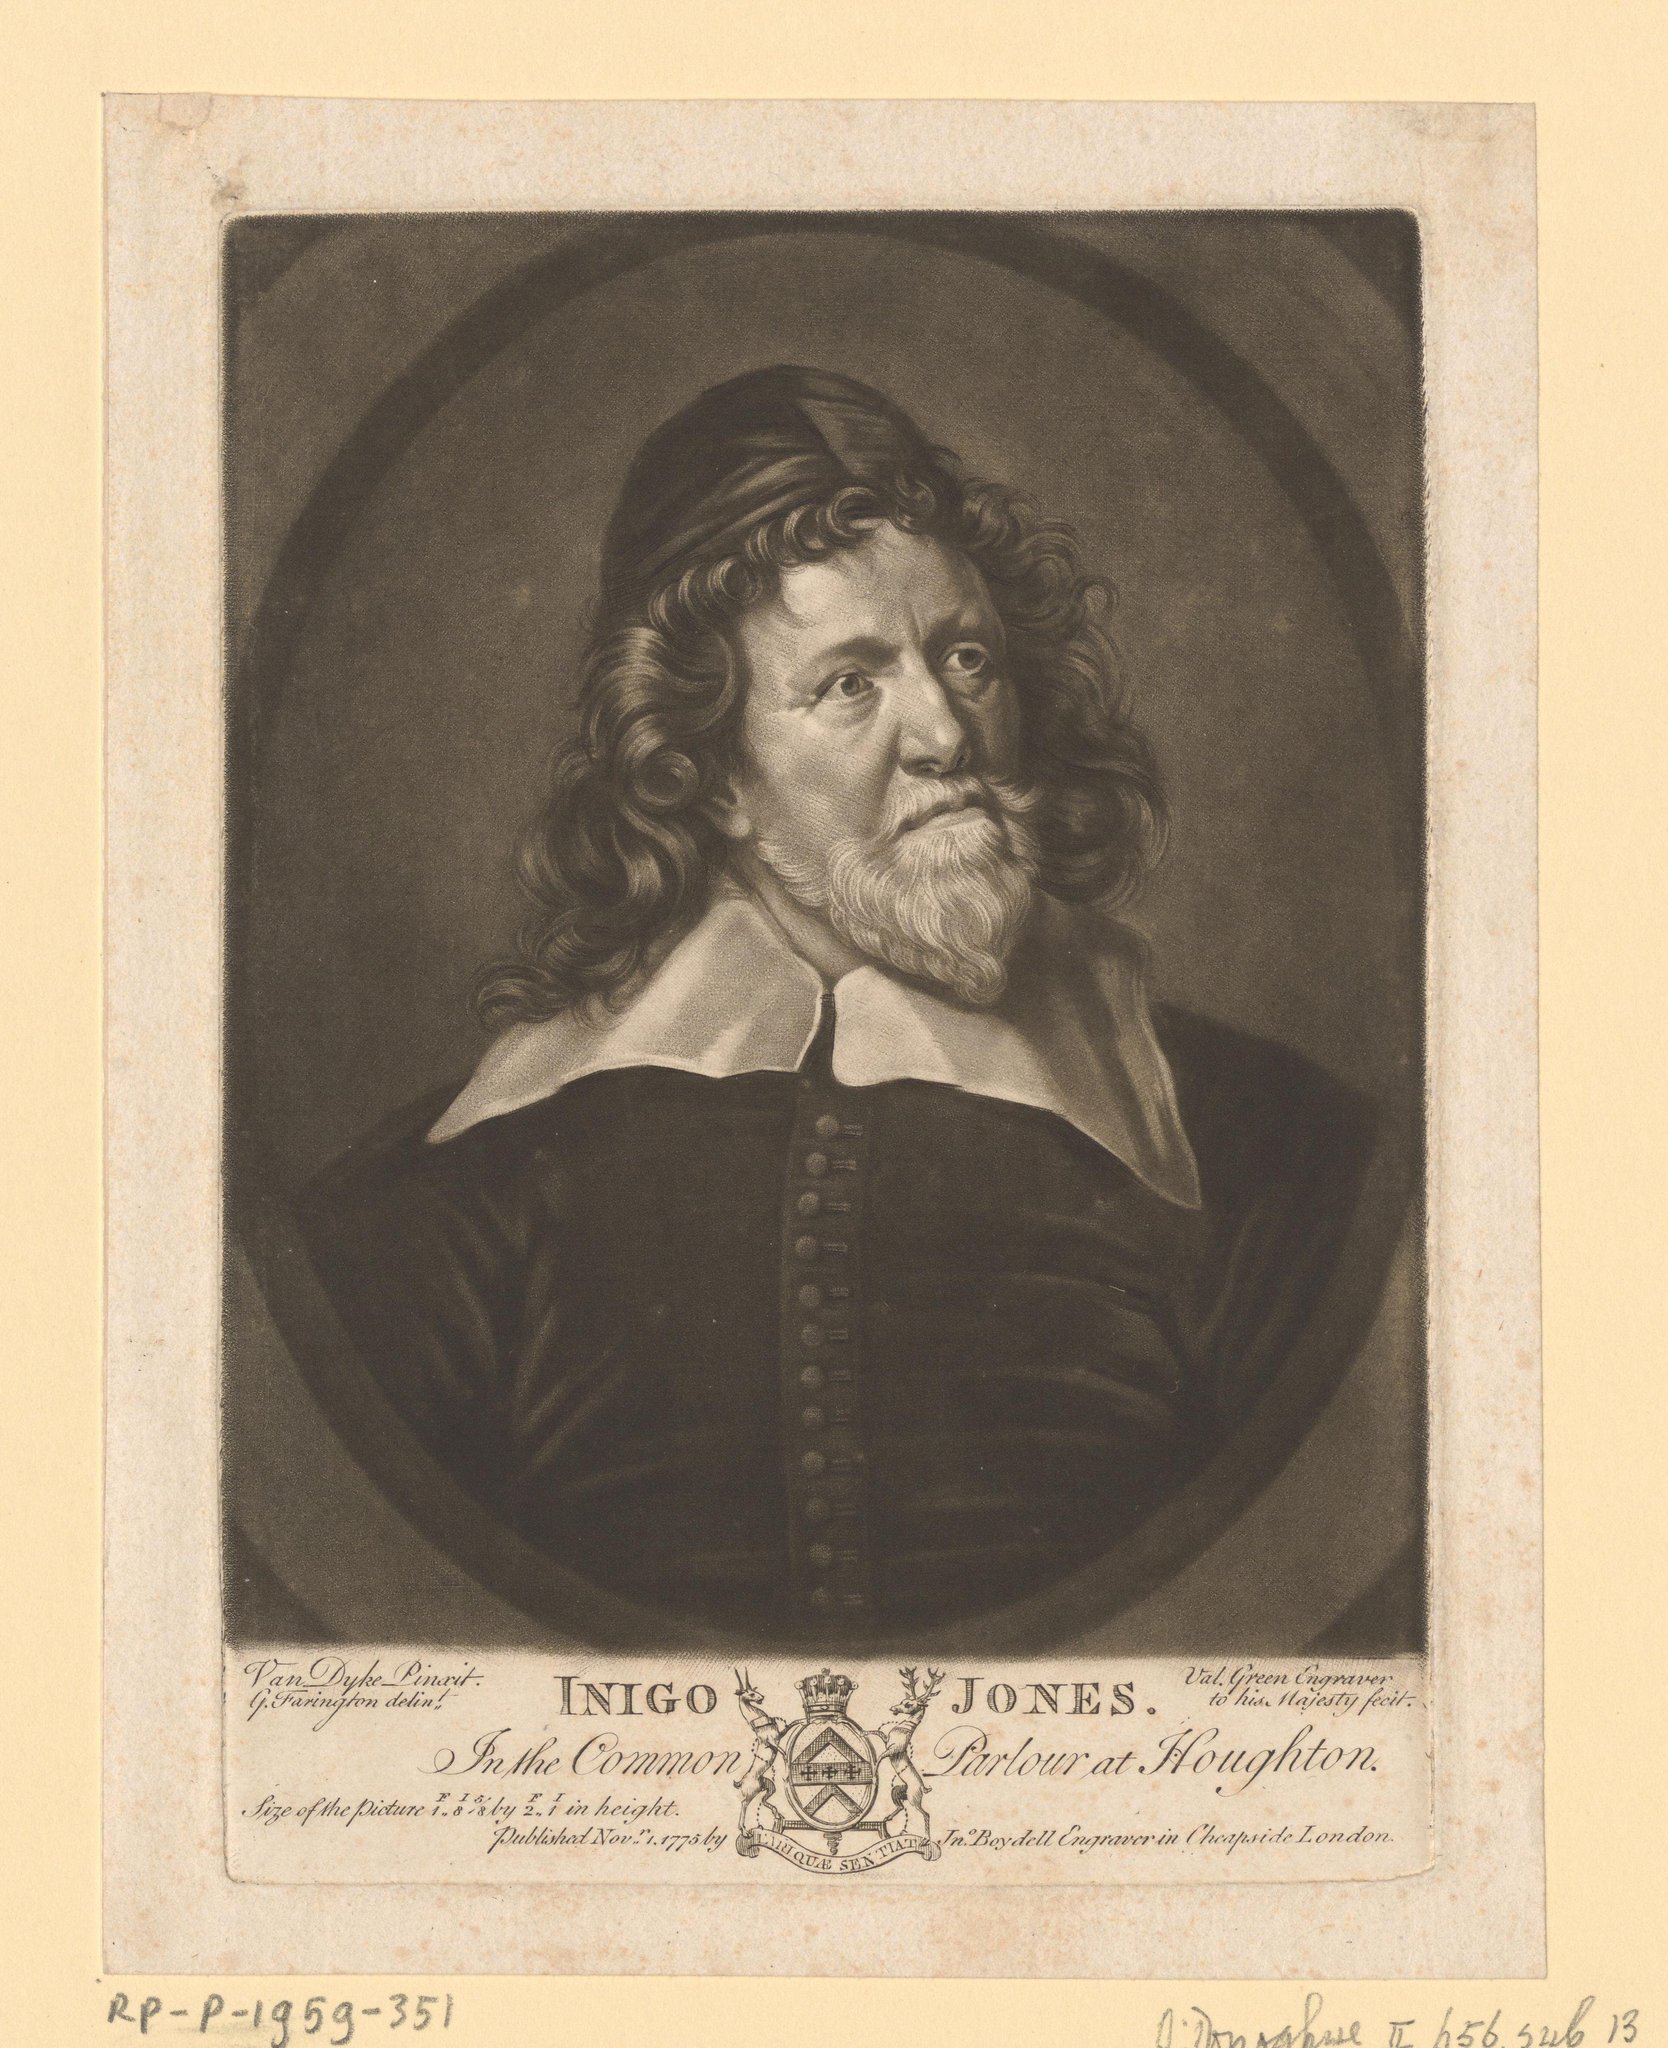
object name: print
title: Portret van Inigo Jones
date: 1775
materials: paper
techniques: engraving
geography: london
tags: london, inigo jones, historical persons, portrait, self-portrait of architect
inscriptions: collector's mark, collector's mark: Lugt 2926